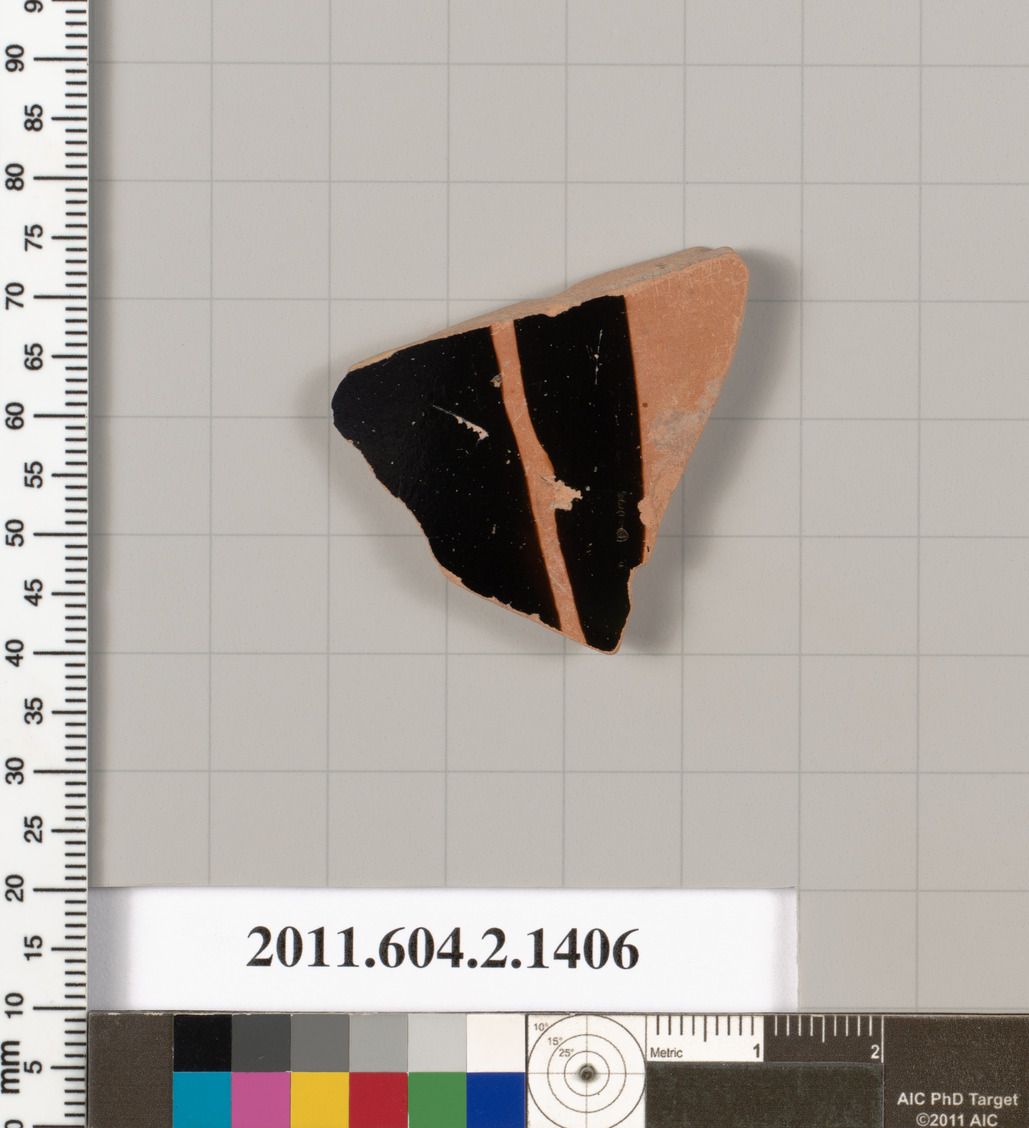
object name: skyphos fragment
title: Terracotta fragment of a skyphos (deep drinking cup)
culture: greek, attic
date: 467-435 BCE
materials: terracotta